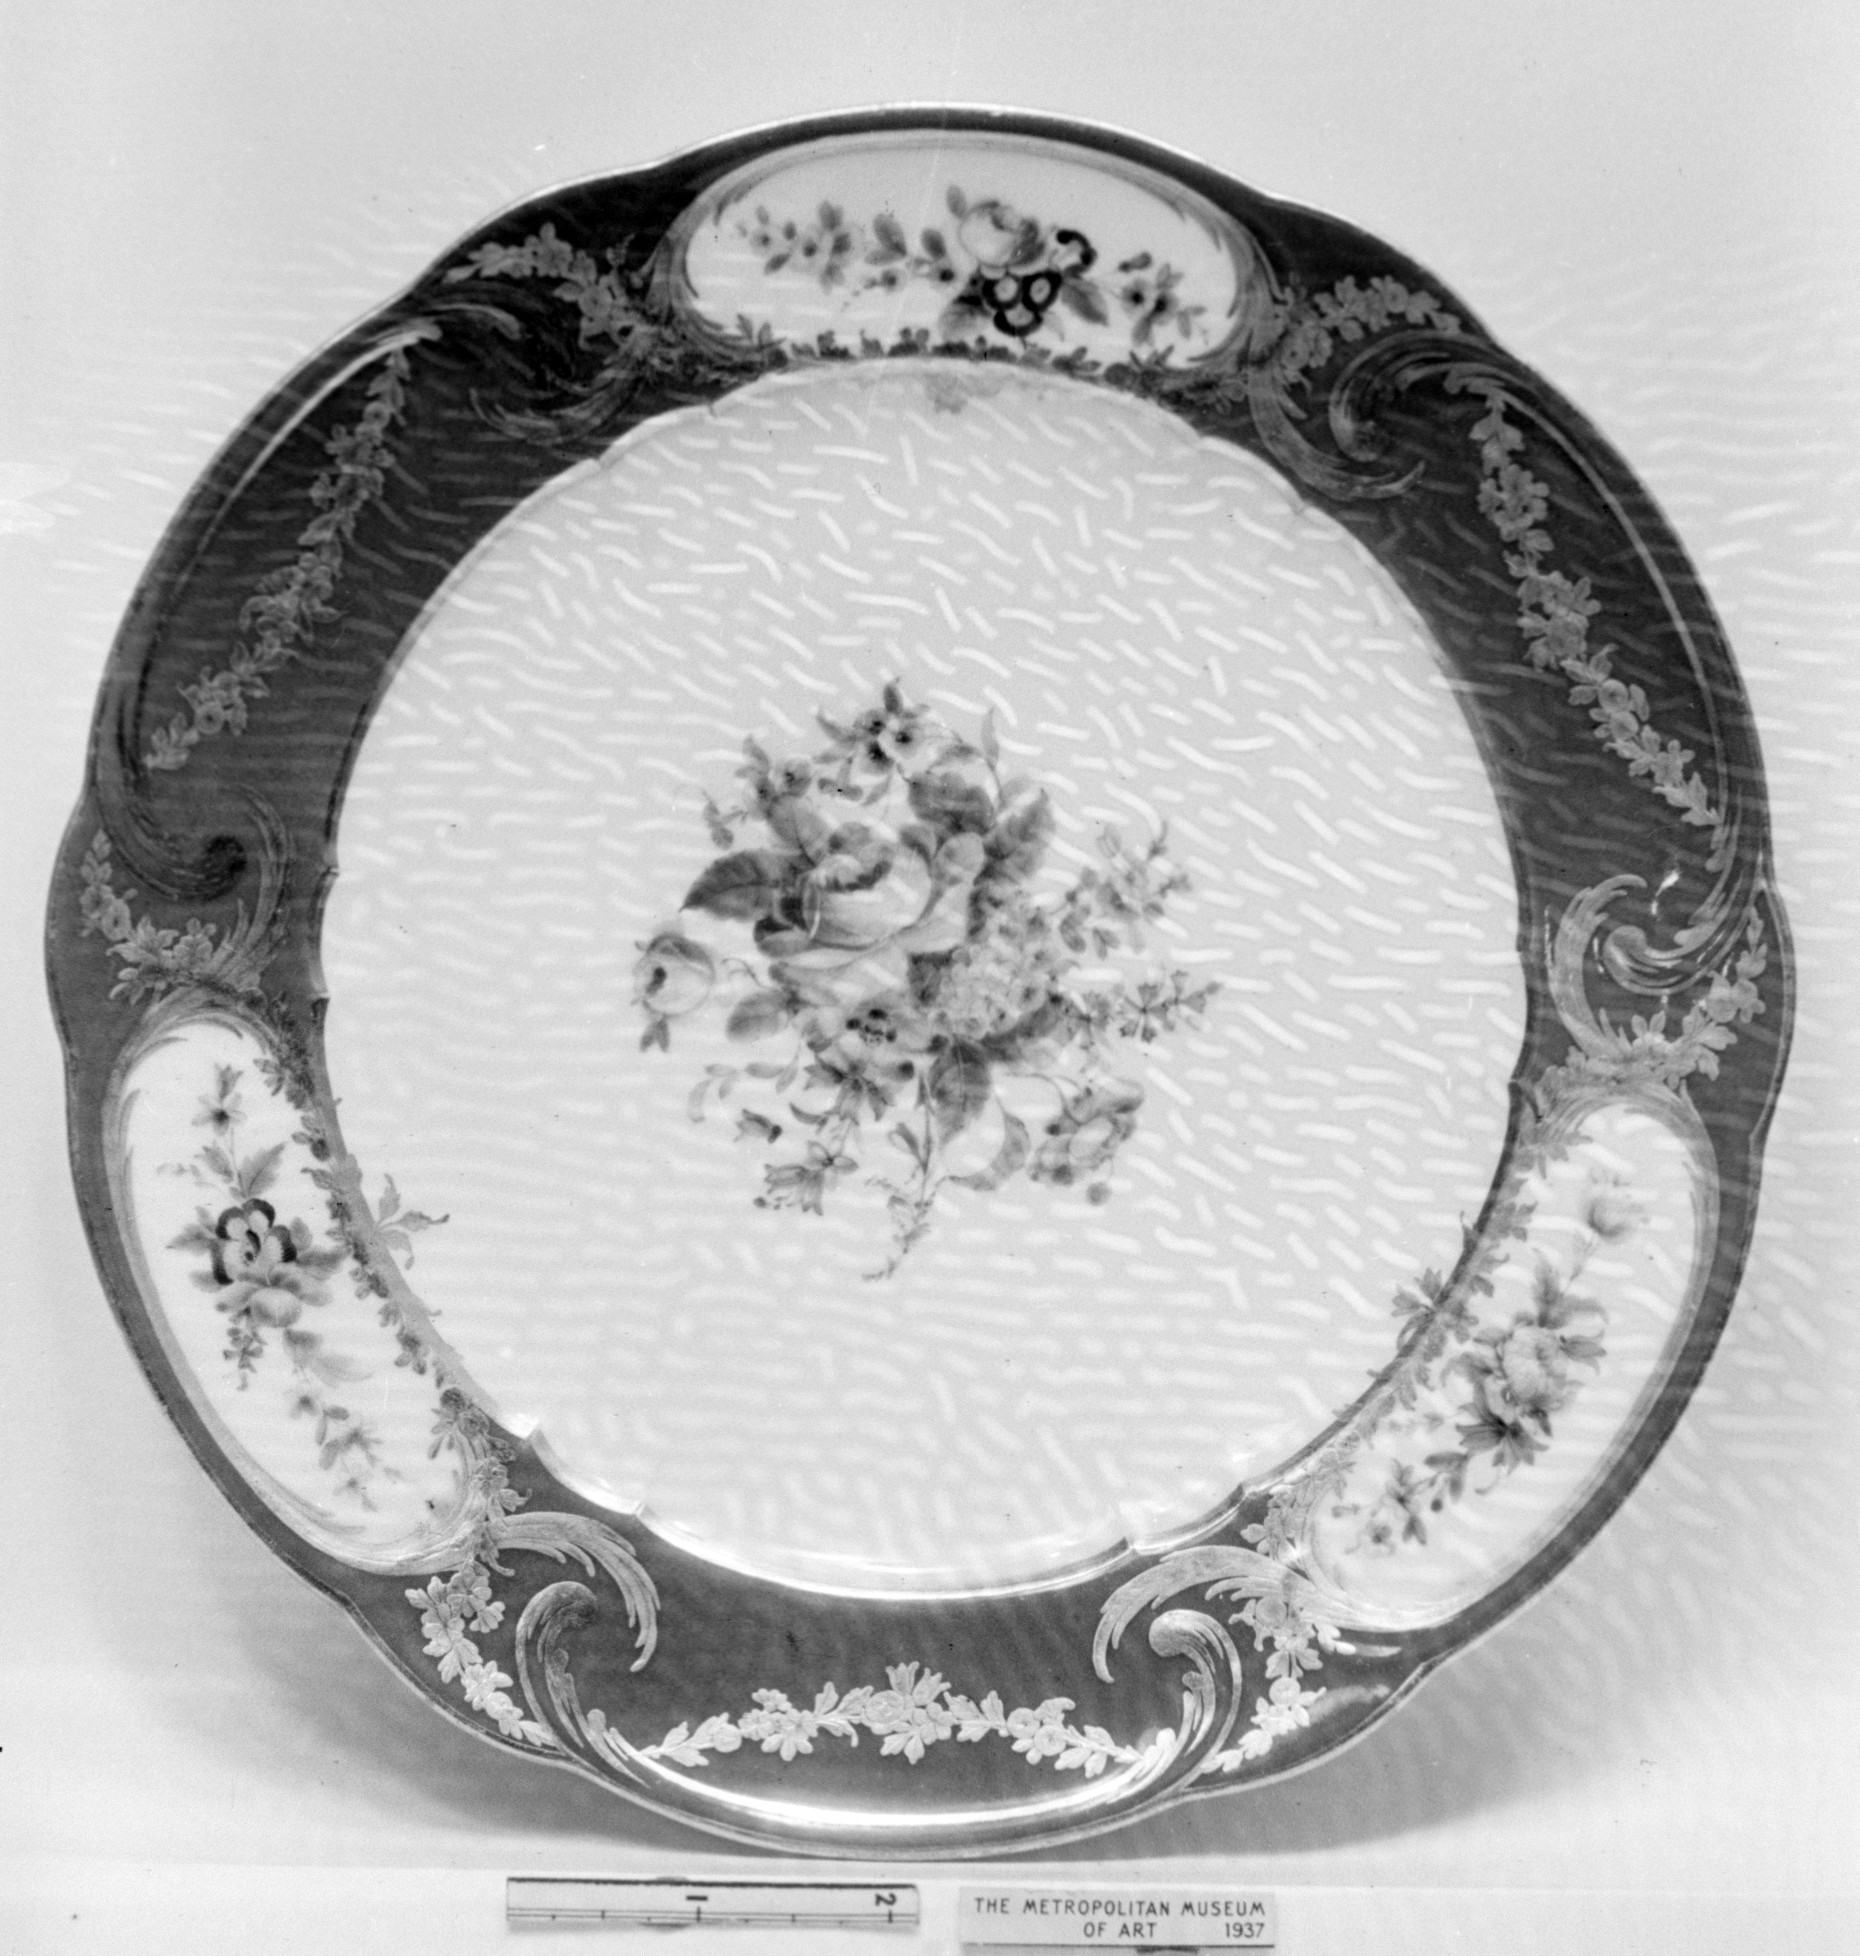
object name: plate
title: Plate (Assiette à palmes) (1 of 102) (part of a service)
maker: sèvres manufactory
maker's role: manufactory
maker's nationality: french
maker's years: 1740-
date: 1780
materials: soft paste porcelain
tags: flowers